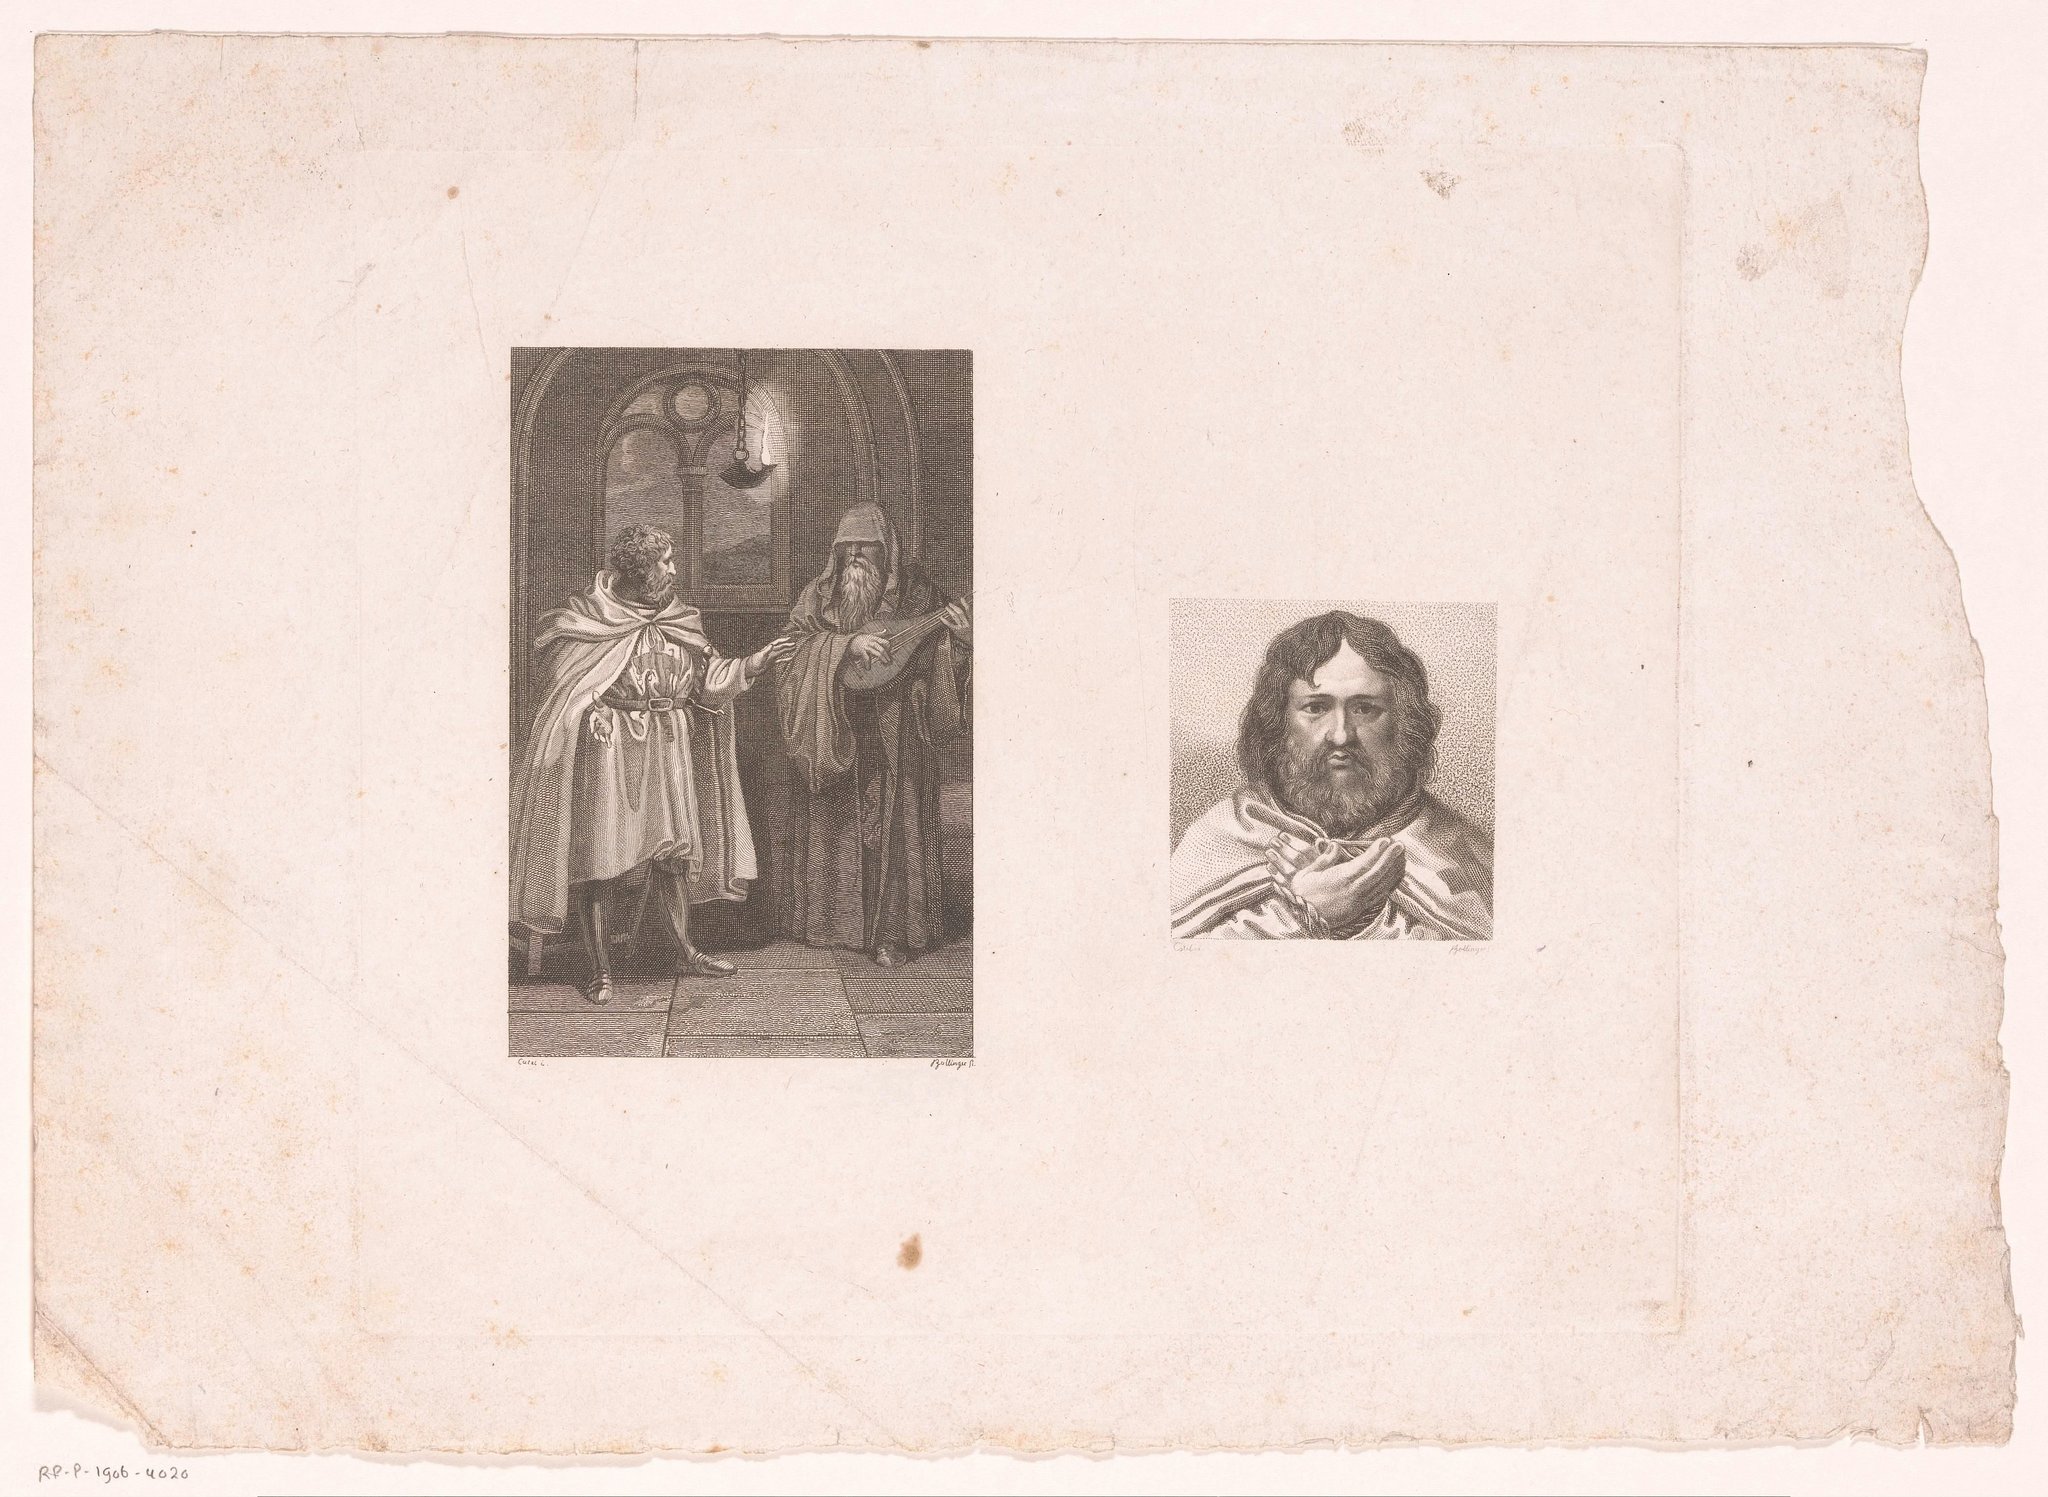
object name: print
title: Interieur met een ridder en een monnik met een snaarinstrument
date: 1787-1825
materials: paper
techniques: etching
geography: berlin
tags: monk(s), friar(s), cithern, mandolin, guitar, balalaika, knight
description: Naast de interieurscène het gezicht van een ridder met gebonden handen.